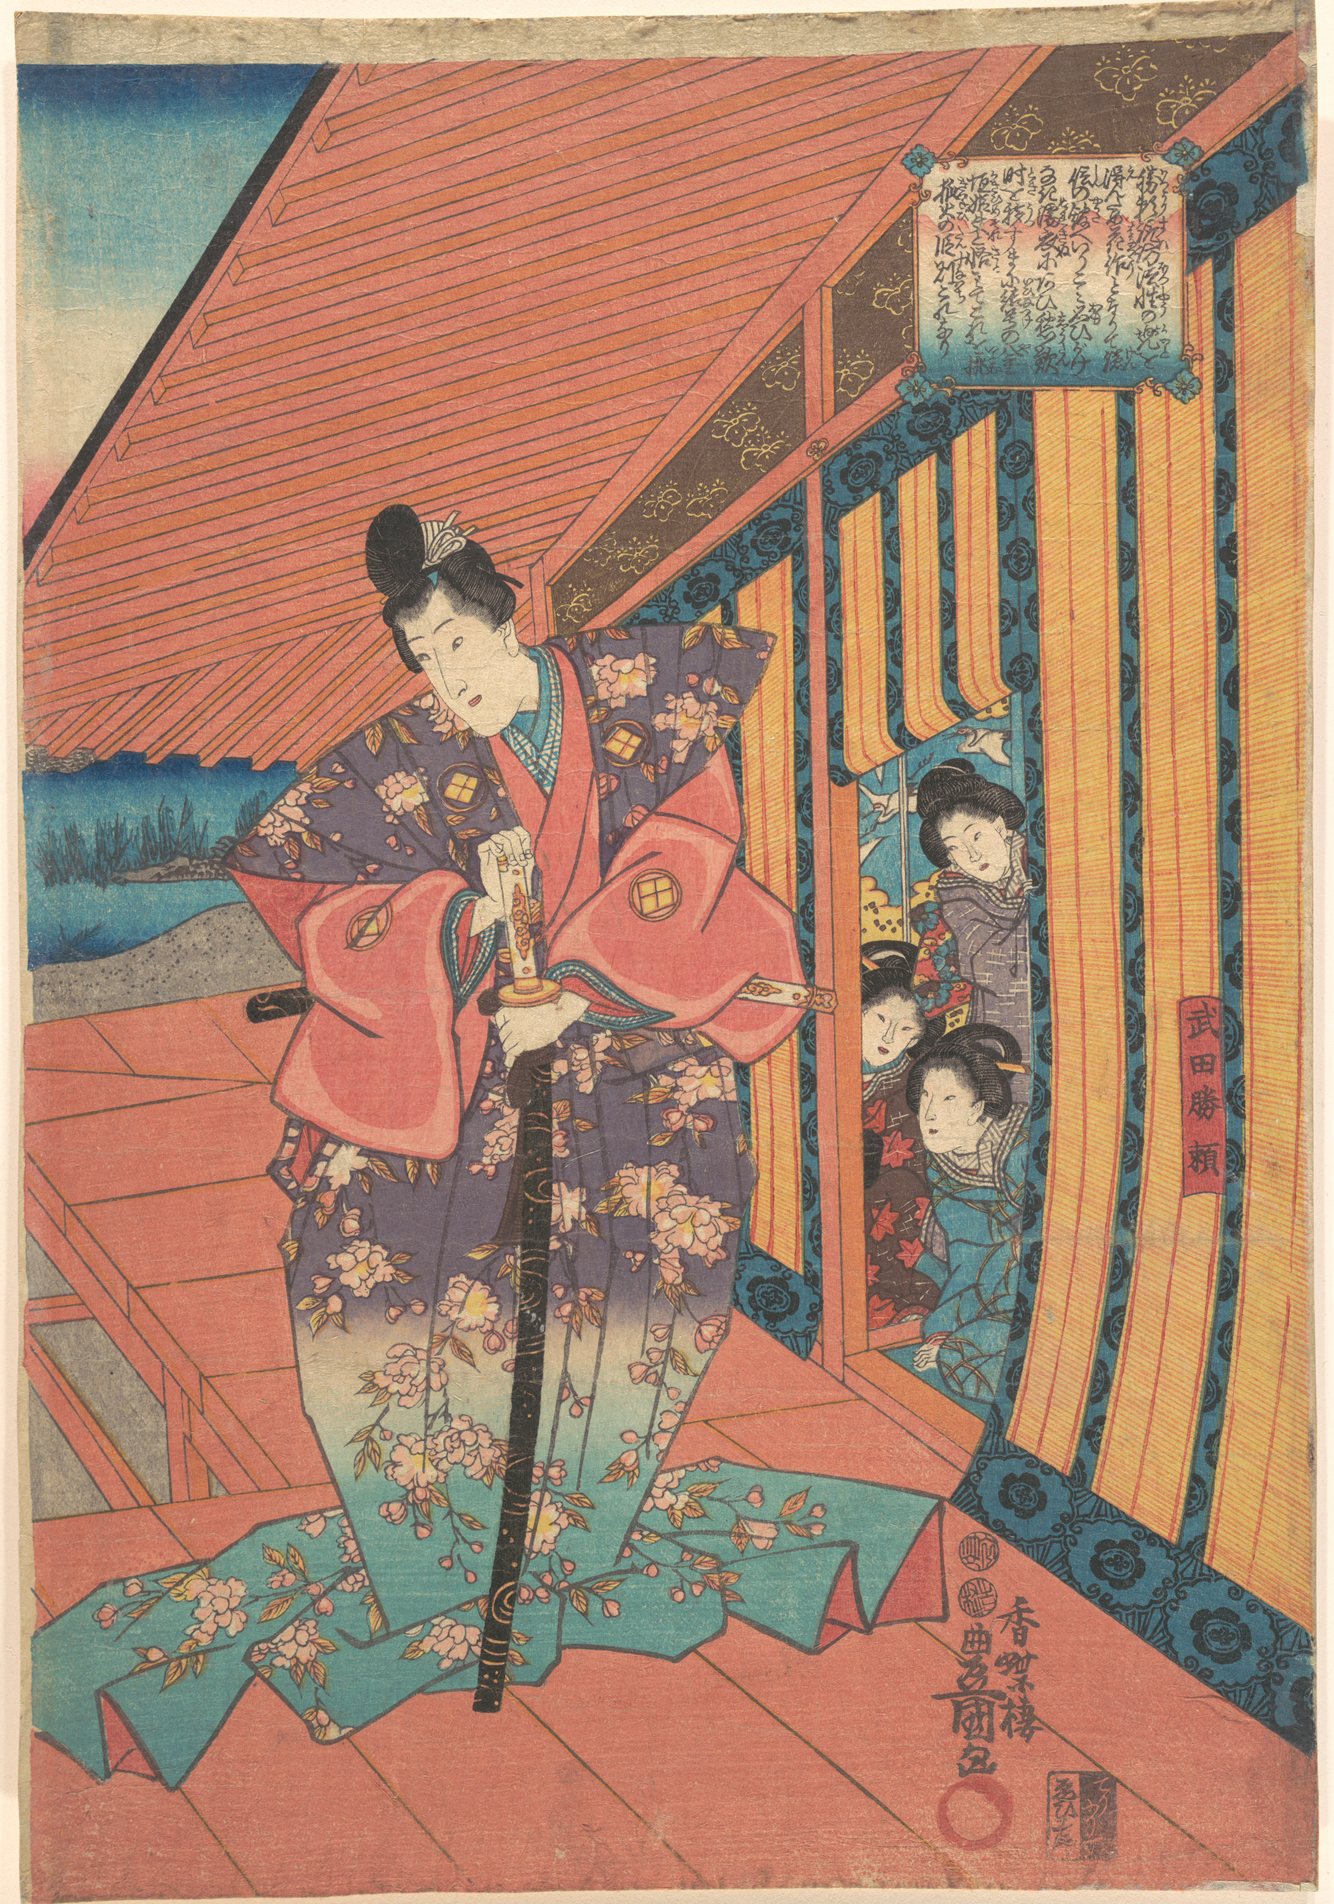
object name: print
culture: japanese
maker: utagawa kunisada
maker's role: artist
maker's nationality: japanese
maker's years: 1786-1864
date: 1786-1854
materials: ink, paper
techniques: woodblock print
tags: swords,men,women